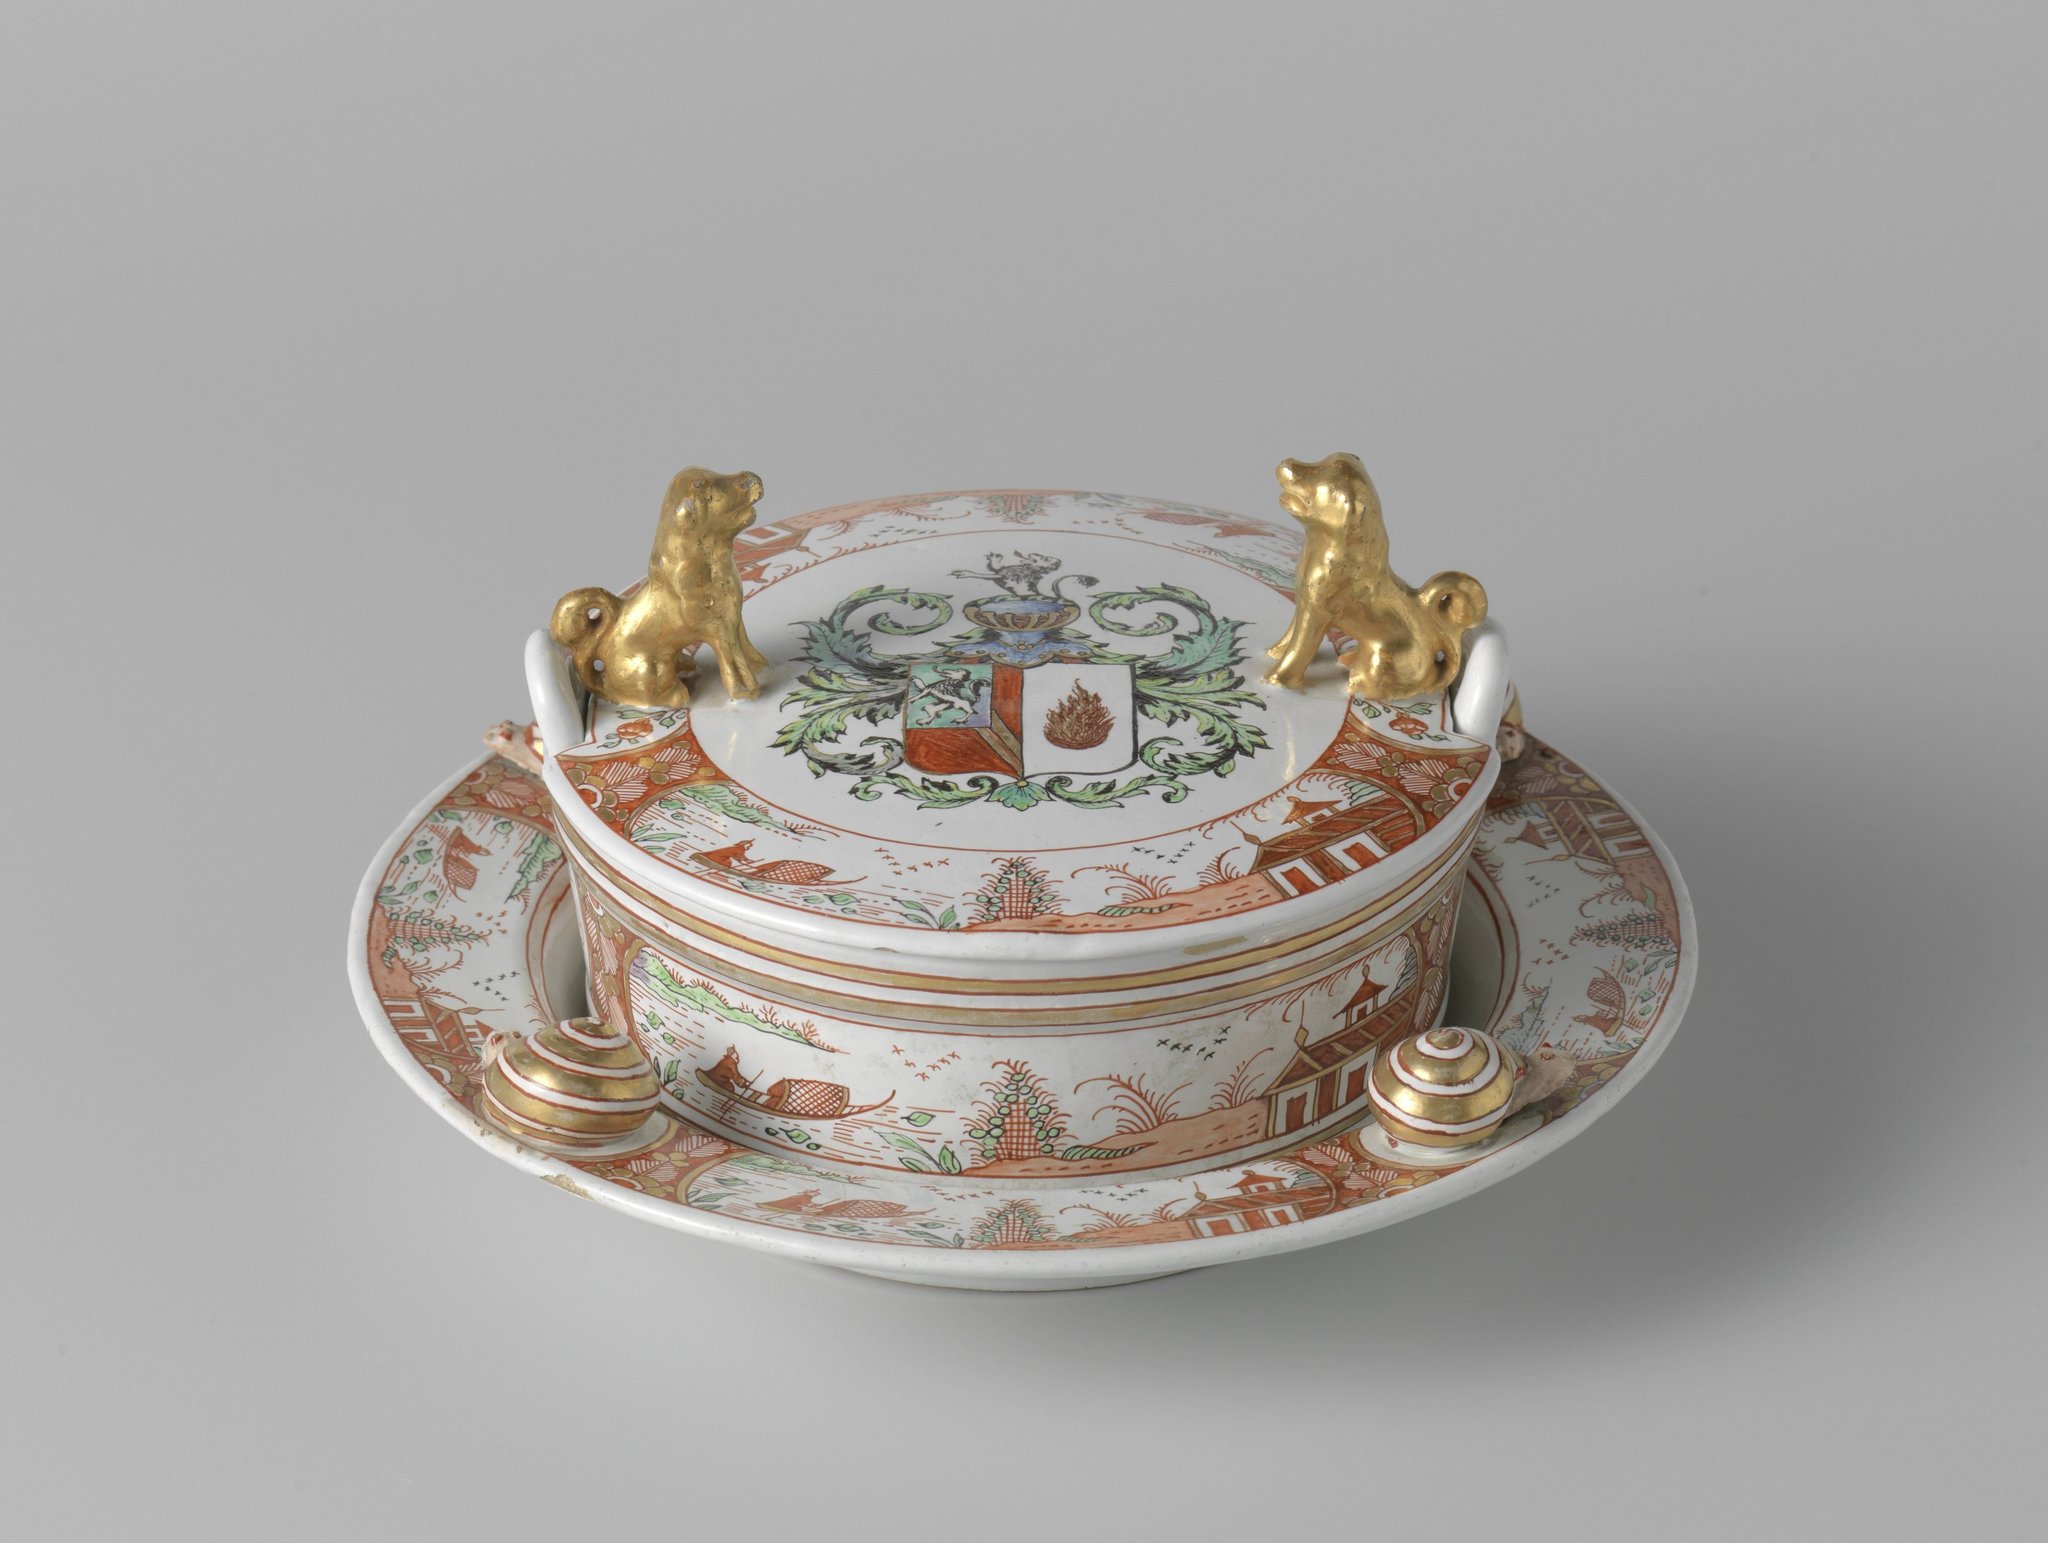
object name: butter dish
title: Botervloot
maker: Anonymous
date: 1740-1765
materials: faience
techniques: kiln, painted, polychromy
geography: delft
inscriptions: mark